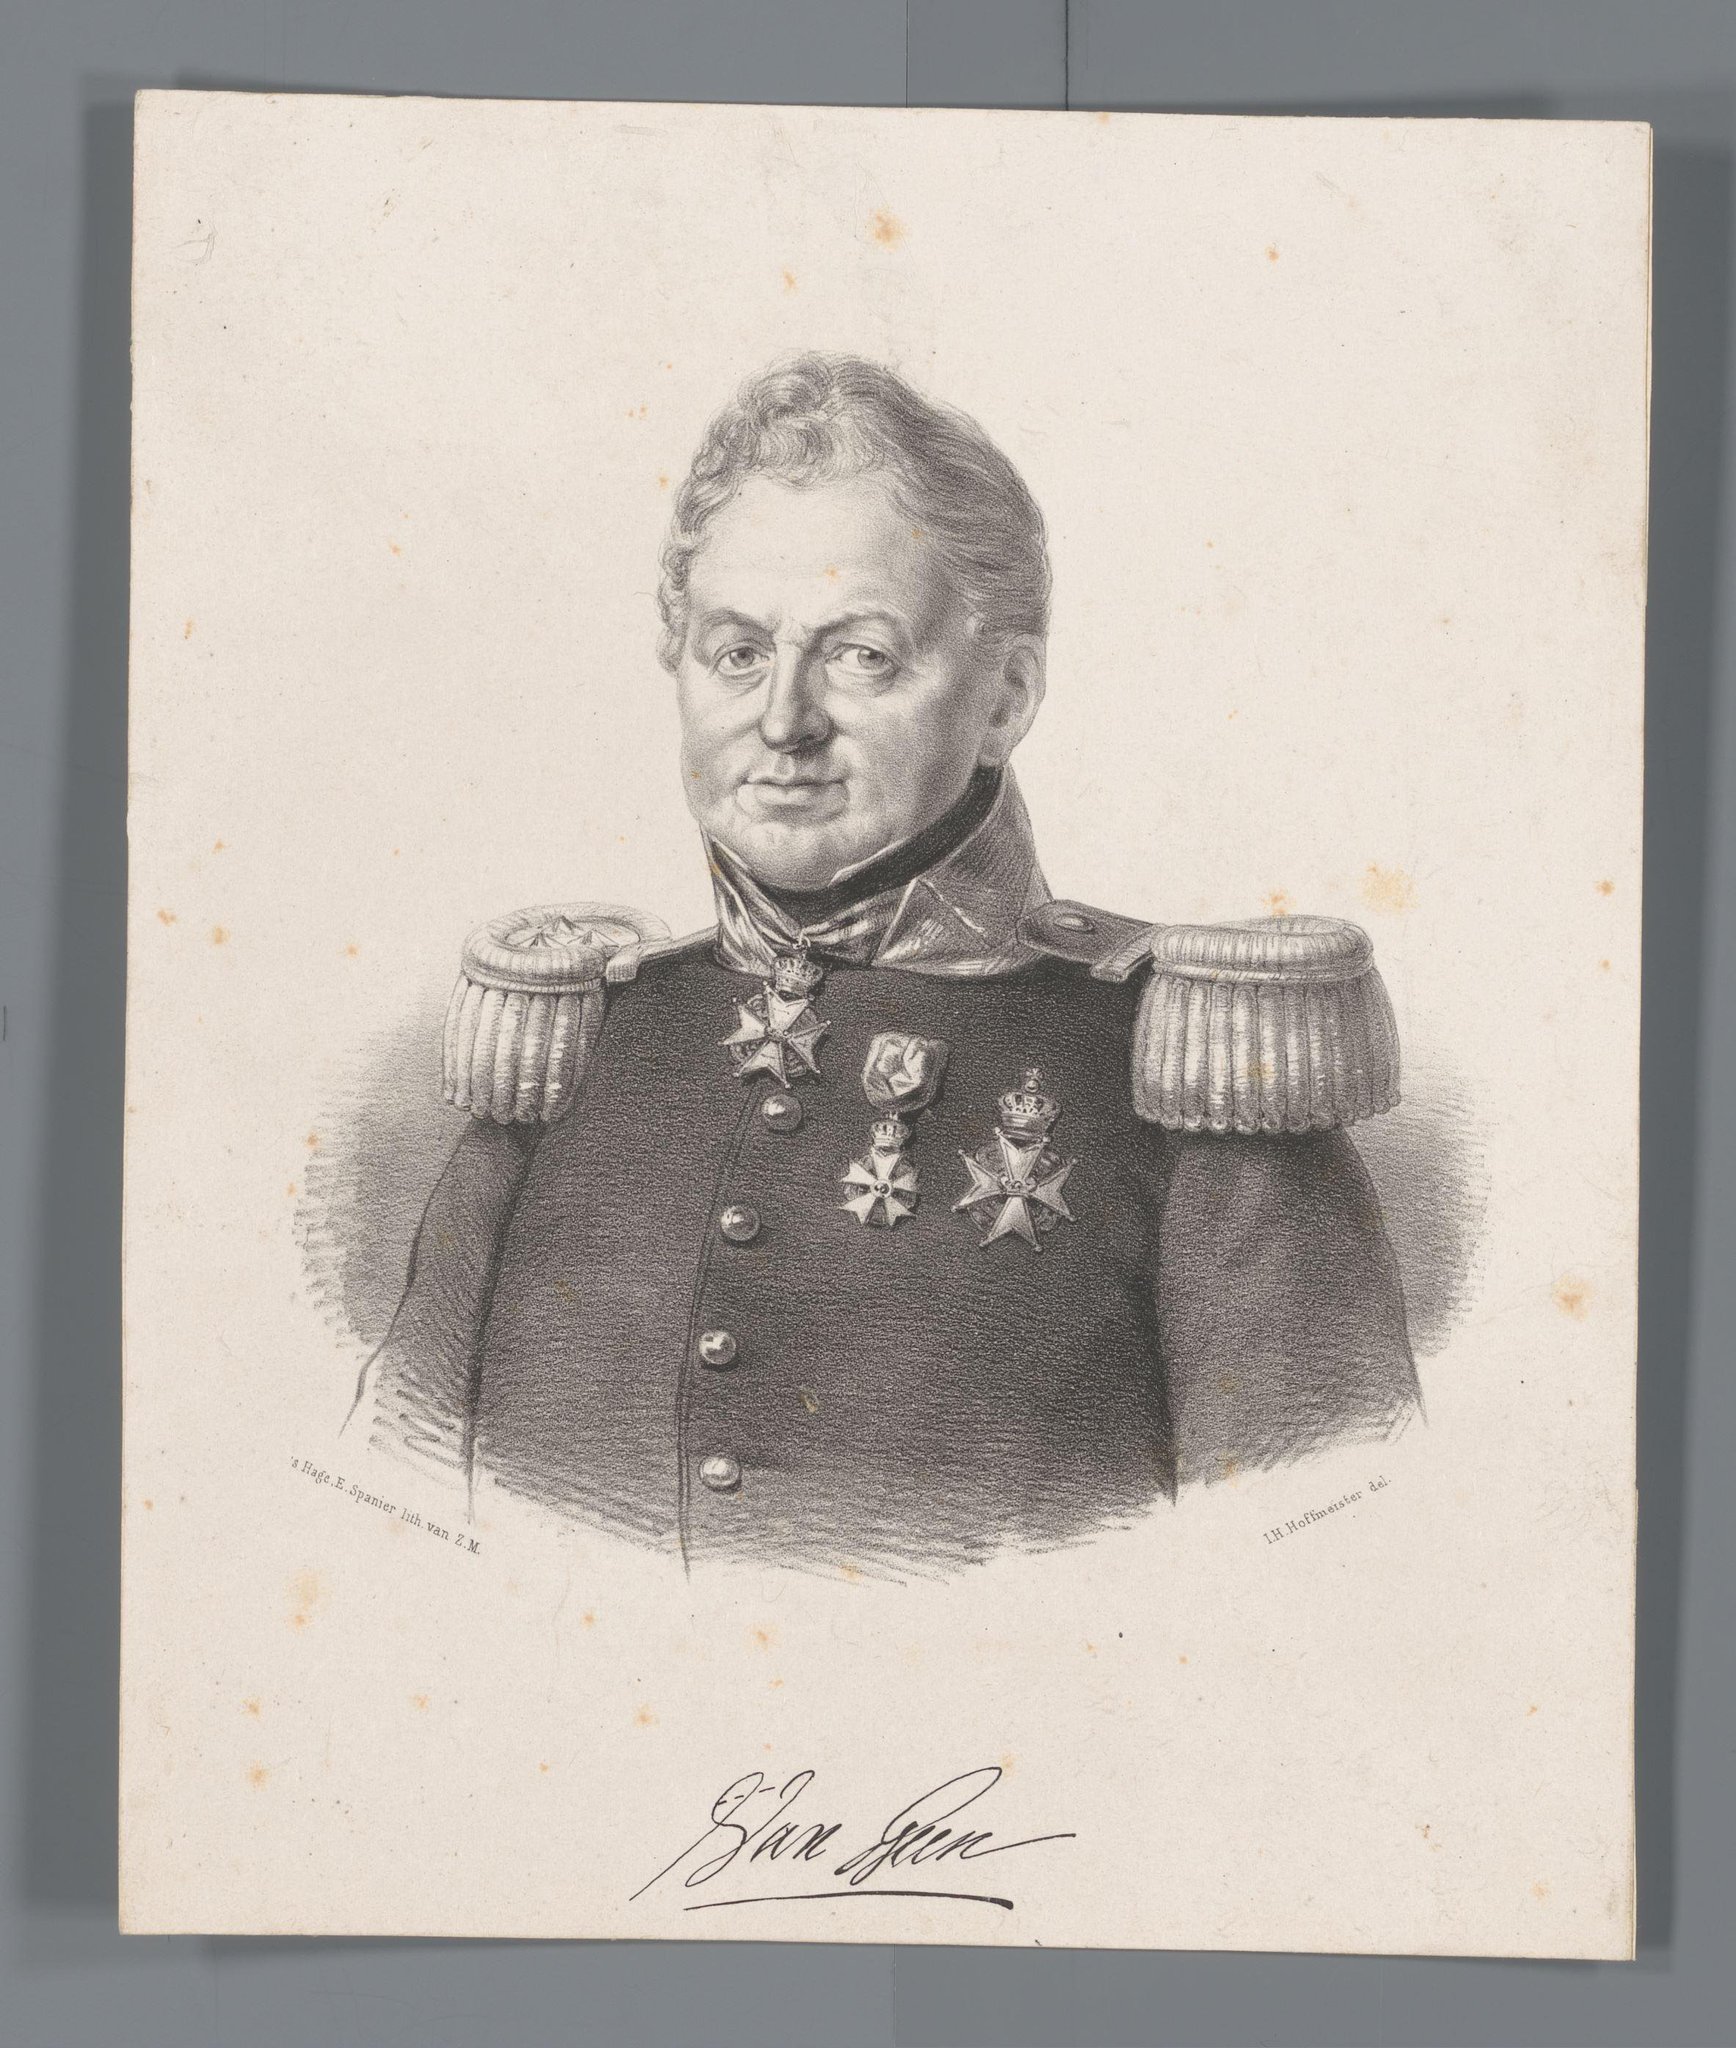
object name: print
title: Portret van Joseph Jacobus baron van Geen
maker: elias spanier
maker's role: print maker, printer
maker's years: 1821-1863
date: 1851-1883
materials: paper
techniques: lithograph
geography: the hague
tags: ghent, historical persons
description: Portret van Joseph Jacobus baron van Geen, borststuk, in uniform, ietwat naar links, met drie eretekens. Onder: handtekening. Hoort bij NG-NM-10388-23-B: levensbeschrijving.